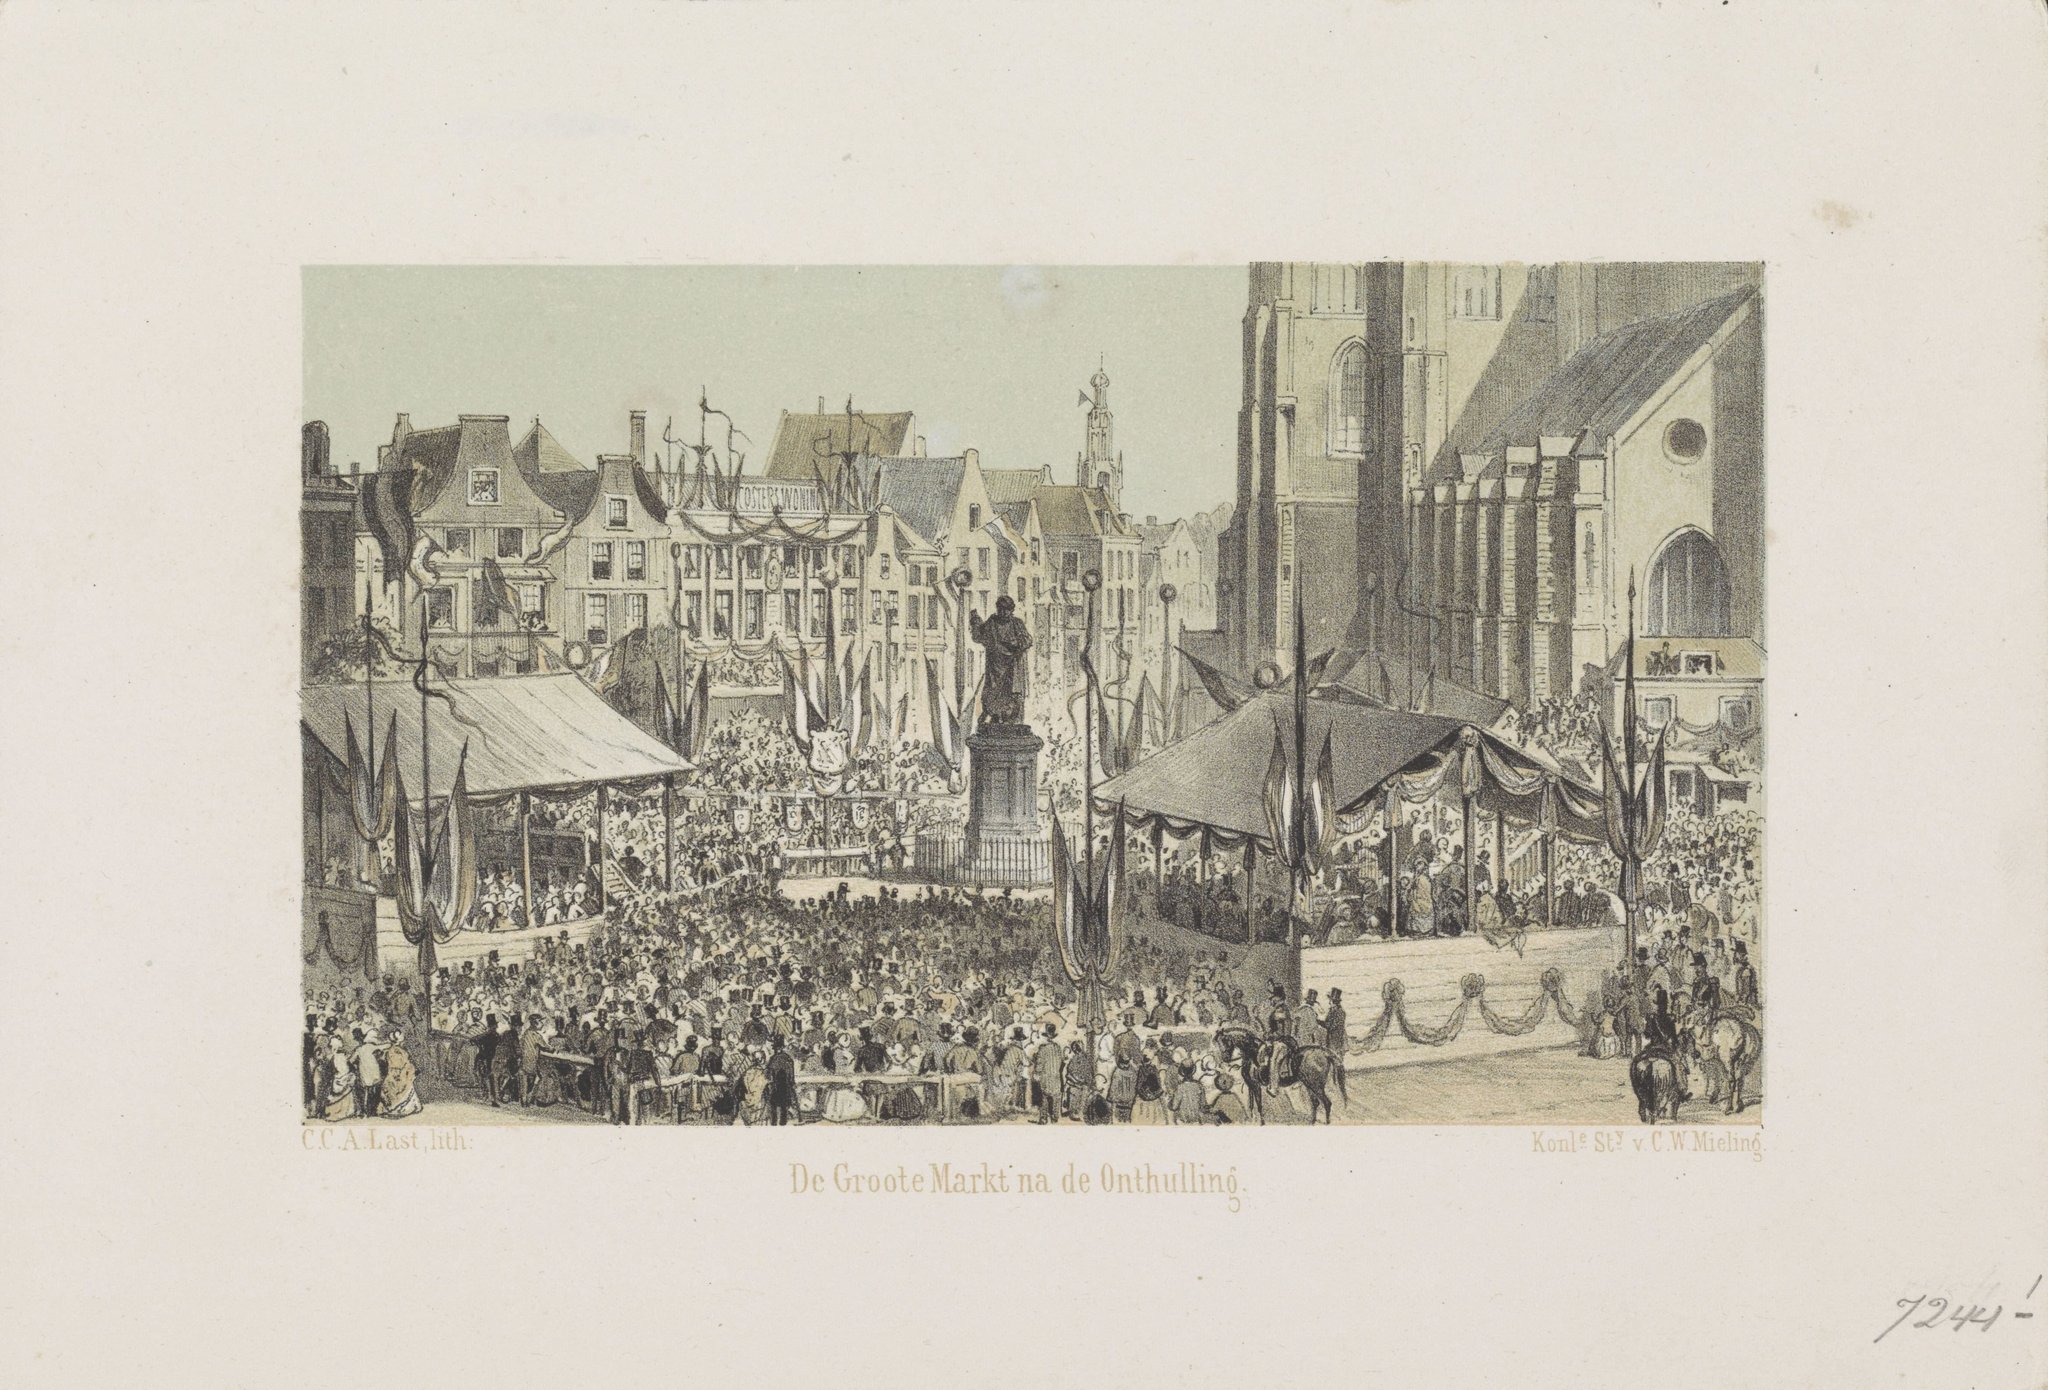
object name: print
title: De Groote Markt na de Onthulling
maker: carel christiaan antony last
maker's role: print maker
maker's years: 1808-1876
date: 1856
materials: paper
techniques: lithograph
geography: netherlands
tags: haarlem, monument, statue, rejoicing on special occasions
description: Gezicht op de Grote Markt te Haarlem na de onthulling van het standbeeld van Laurens Coster, 15-17 juli 1856. Onderdeel van een serie van zes platen van feestelijkheden rondom de onthulling van het standbeeld.